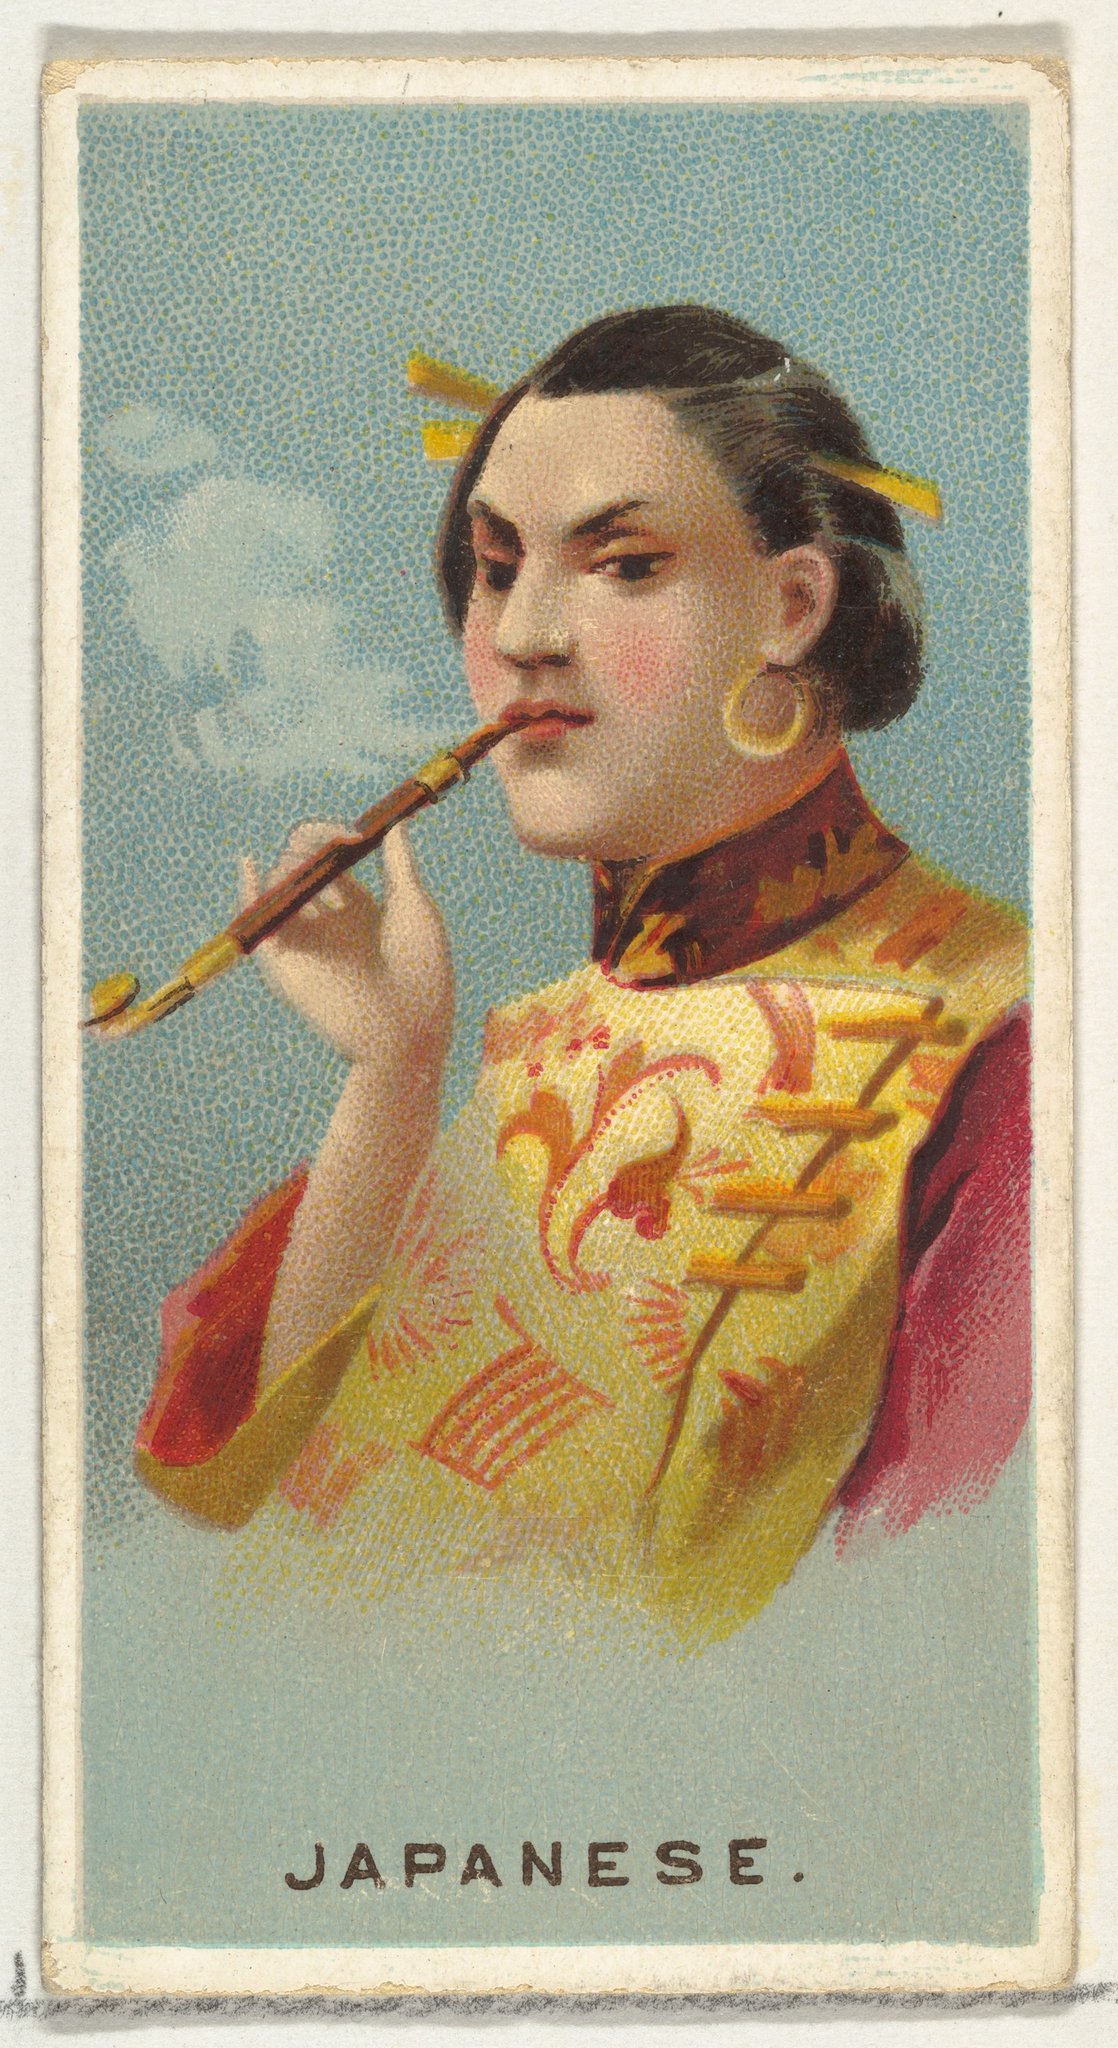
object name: print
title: Japanese, from World's Smokers series (N33) for Allen & Ginter Cigarettes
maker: allen & ginter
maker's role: publisher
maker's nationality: american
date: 1888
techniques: color lithograph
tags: women,smoking